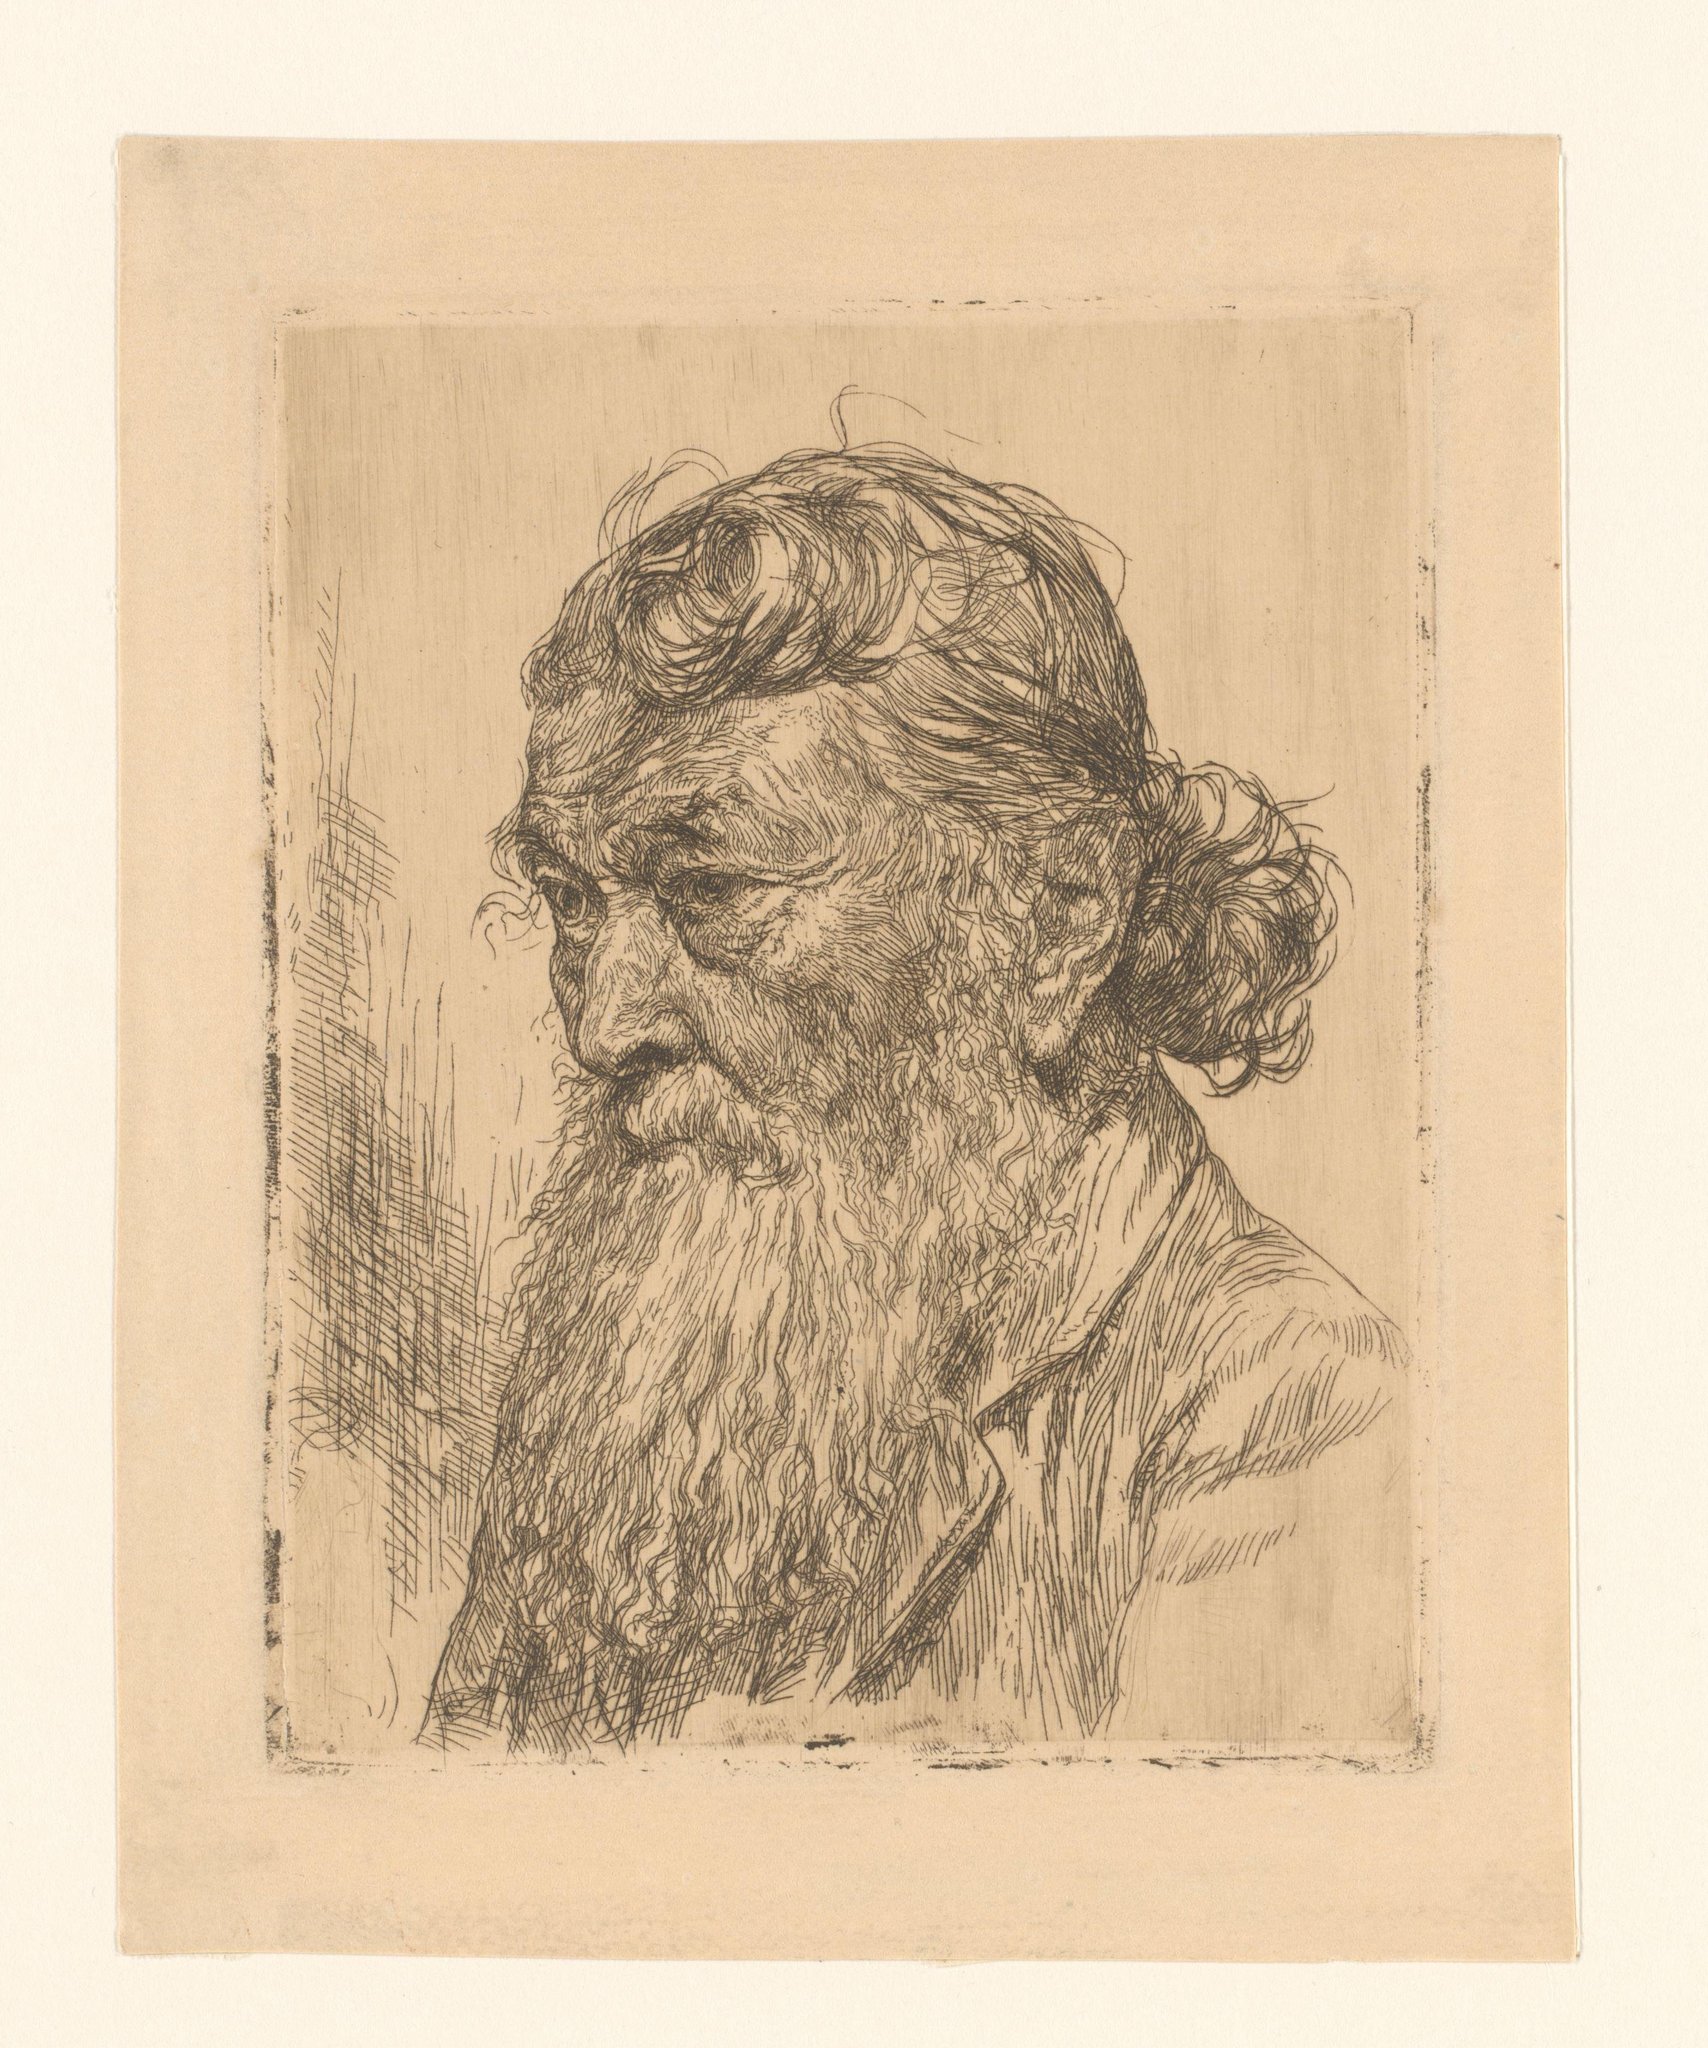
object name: print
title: Hoofd van een oude man met baard en haar in een knot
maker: Anonymous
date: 1800-1899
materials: paper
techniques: etching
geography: netherlands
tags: old man, beard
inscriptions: collector's mark: Lugt 2228